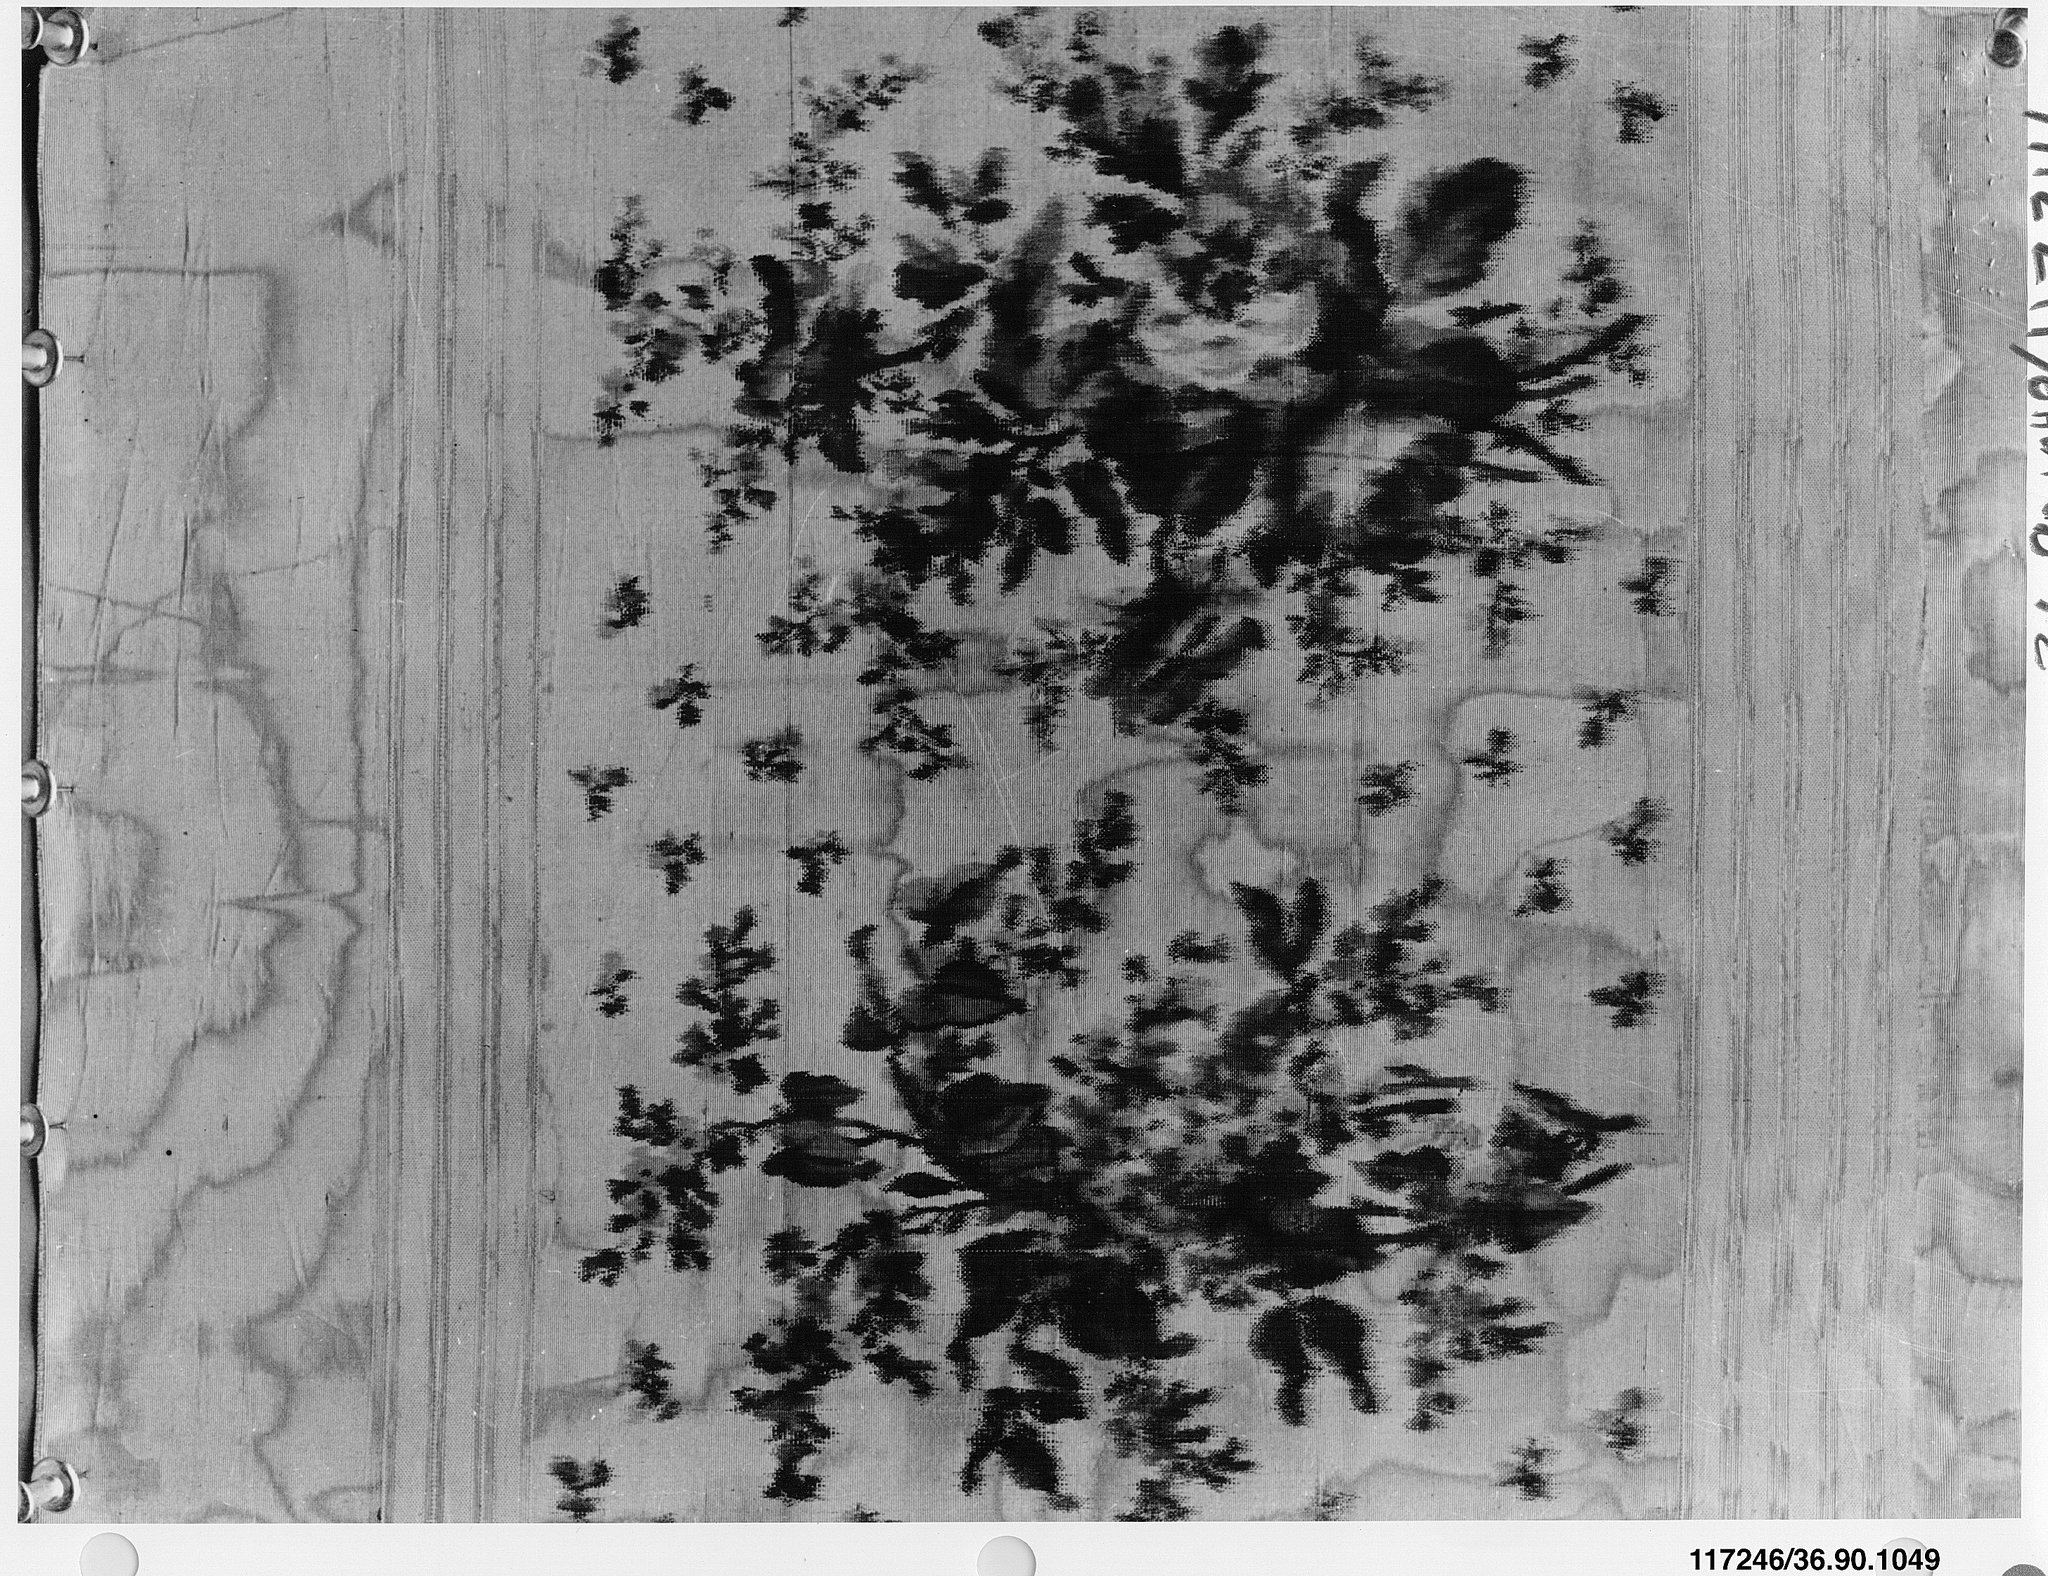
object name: piece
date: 1801-1900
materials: silk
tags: flowers